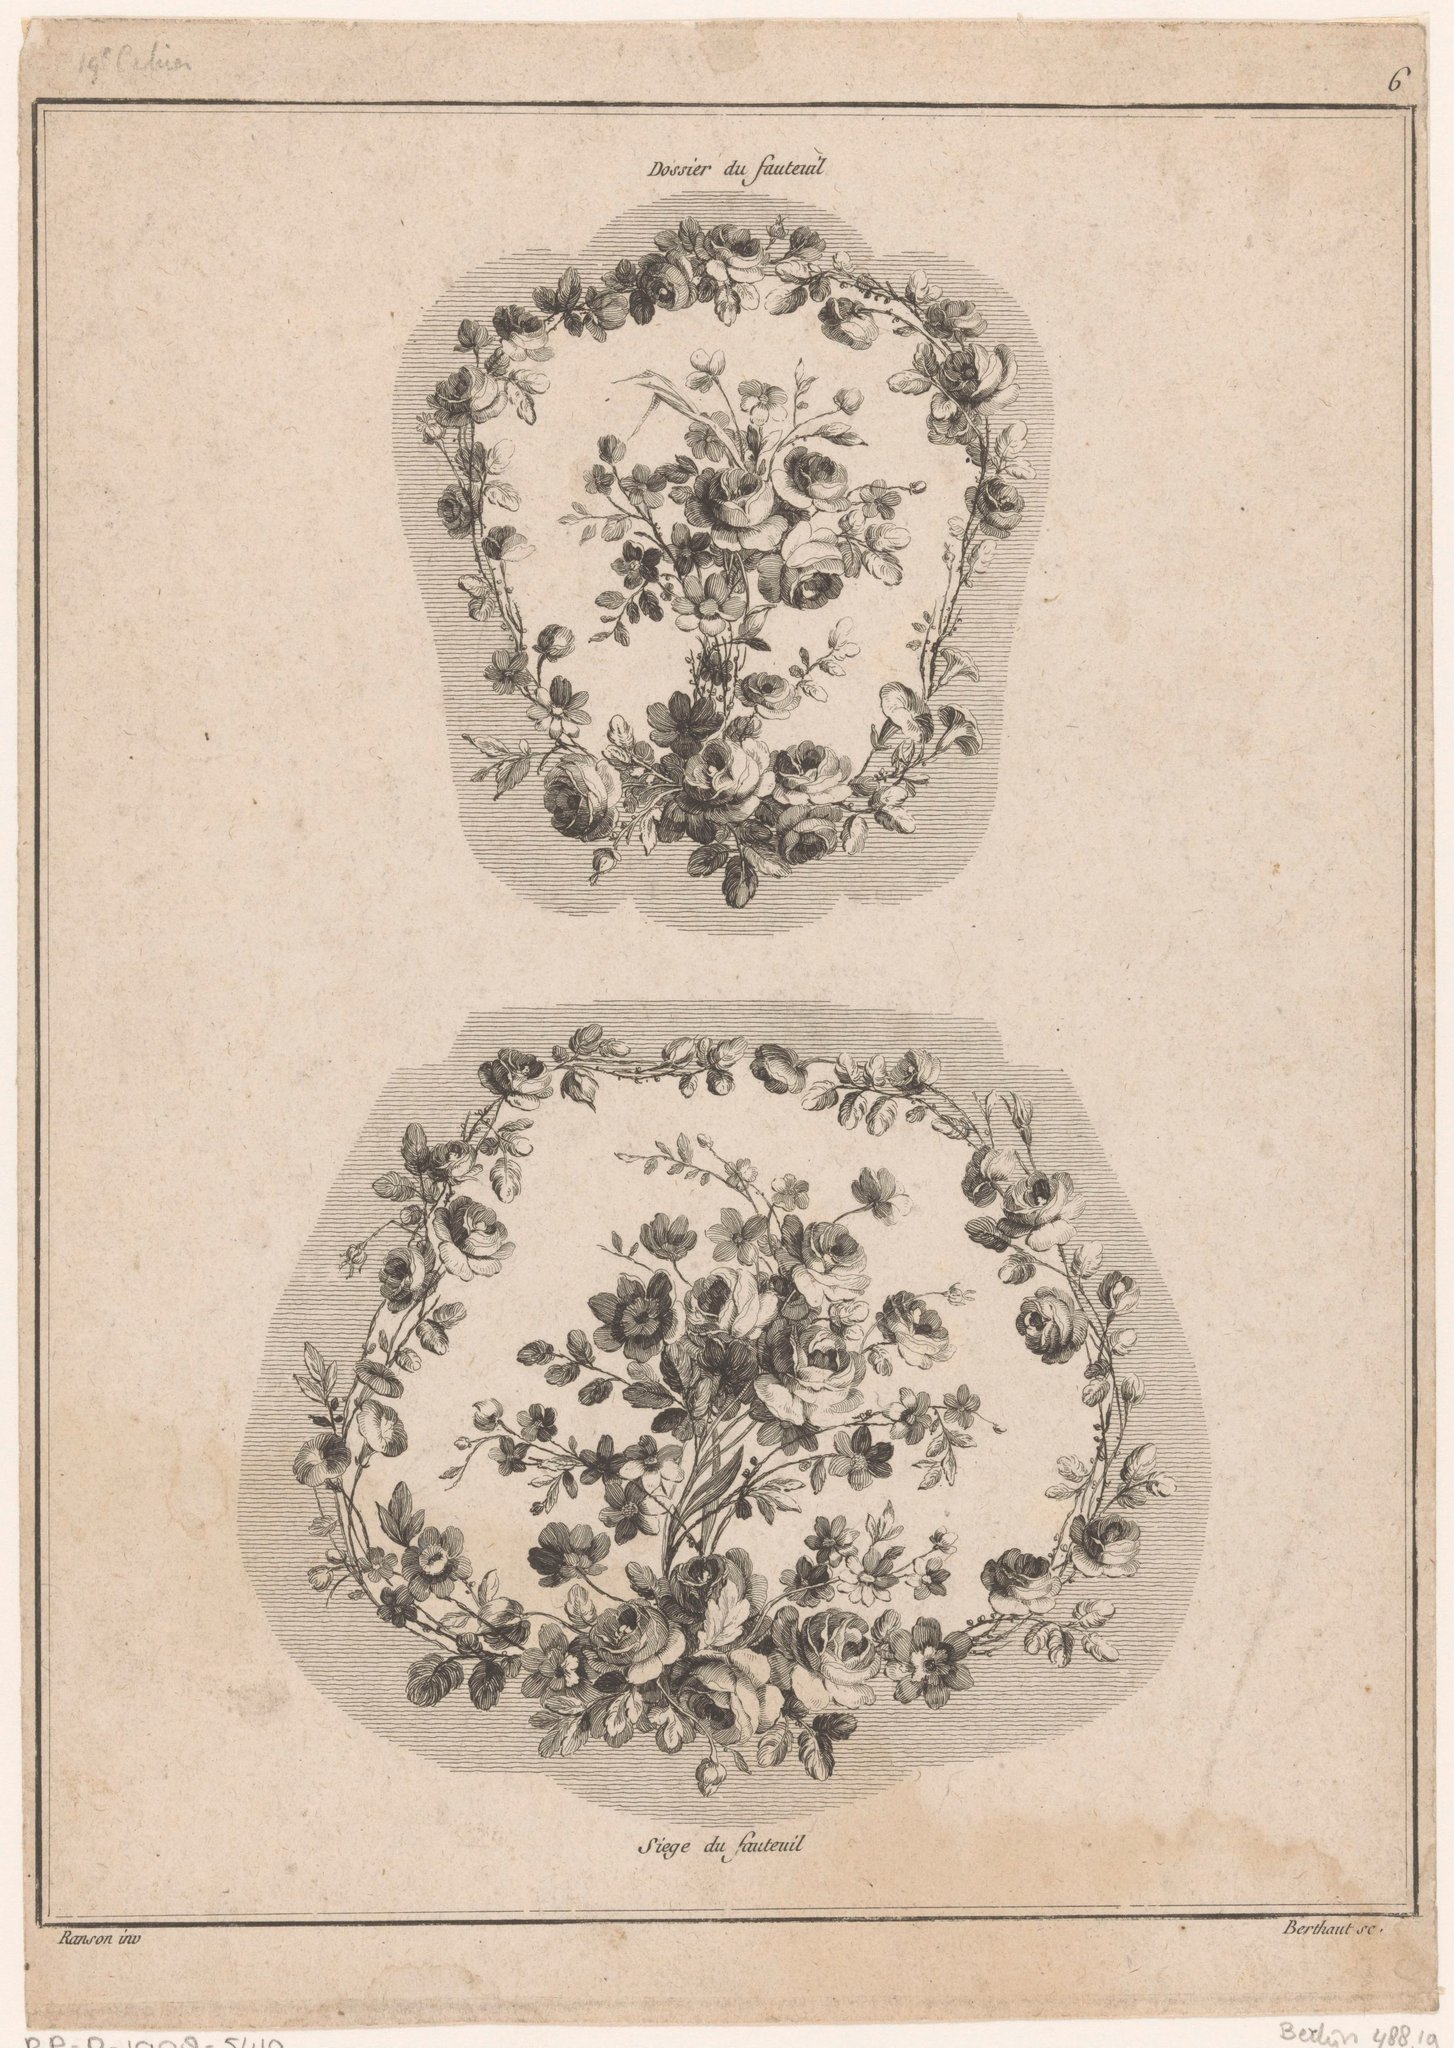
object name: print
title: Stoelbekleding met bloemen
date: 1778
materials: paper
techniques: etching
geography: paris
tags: chair, flowers ~ ornament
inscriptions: collector's mark: Lugt 2228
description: Rug- en zitbekleding met een omlijsting van bloemen rondom een boeket.